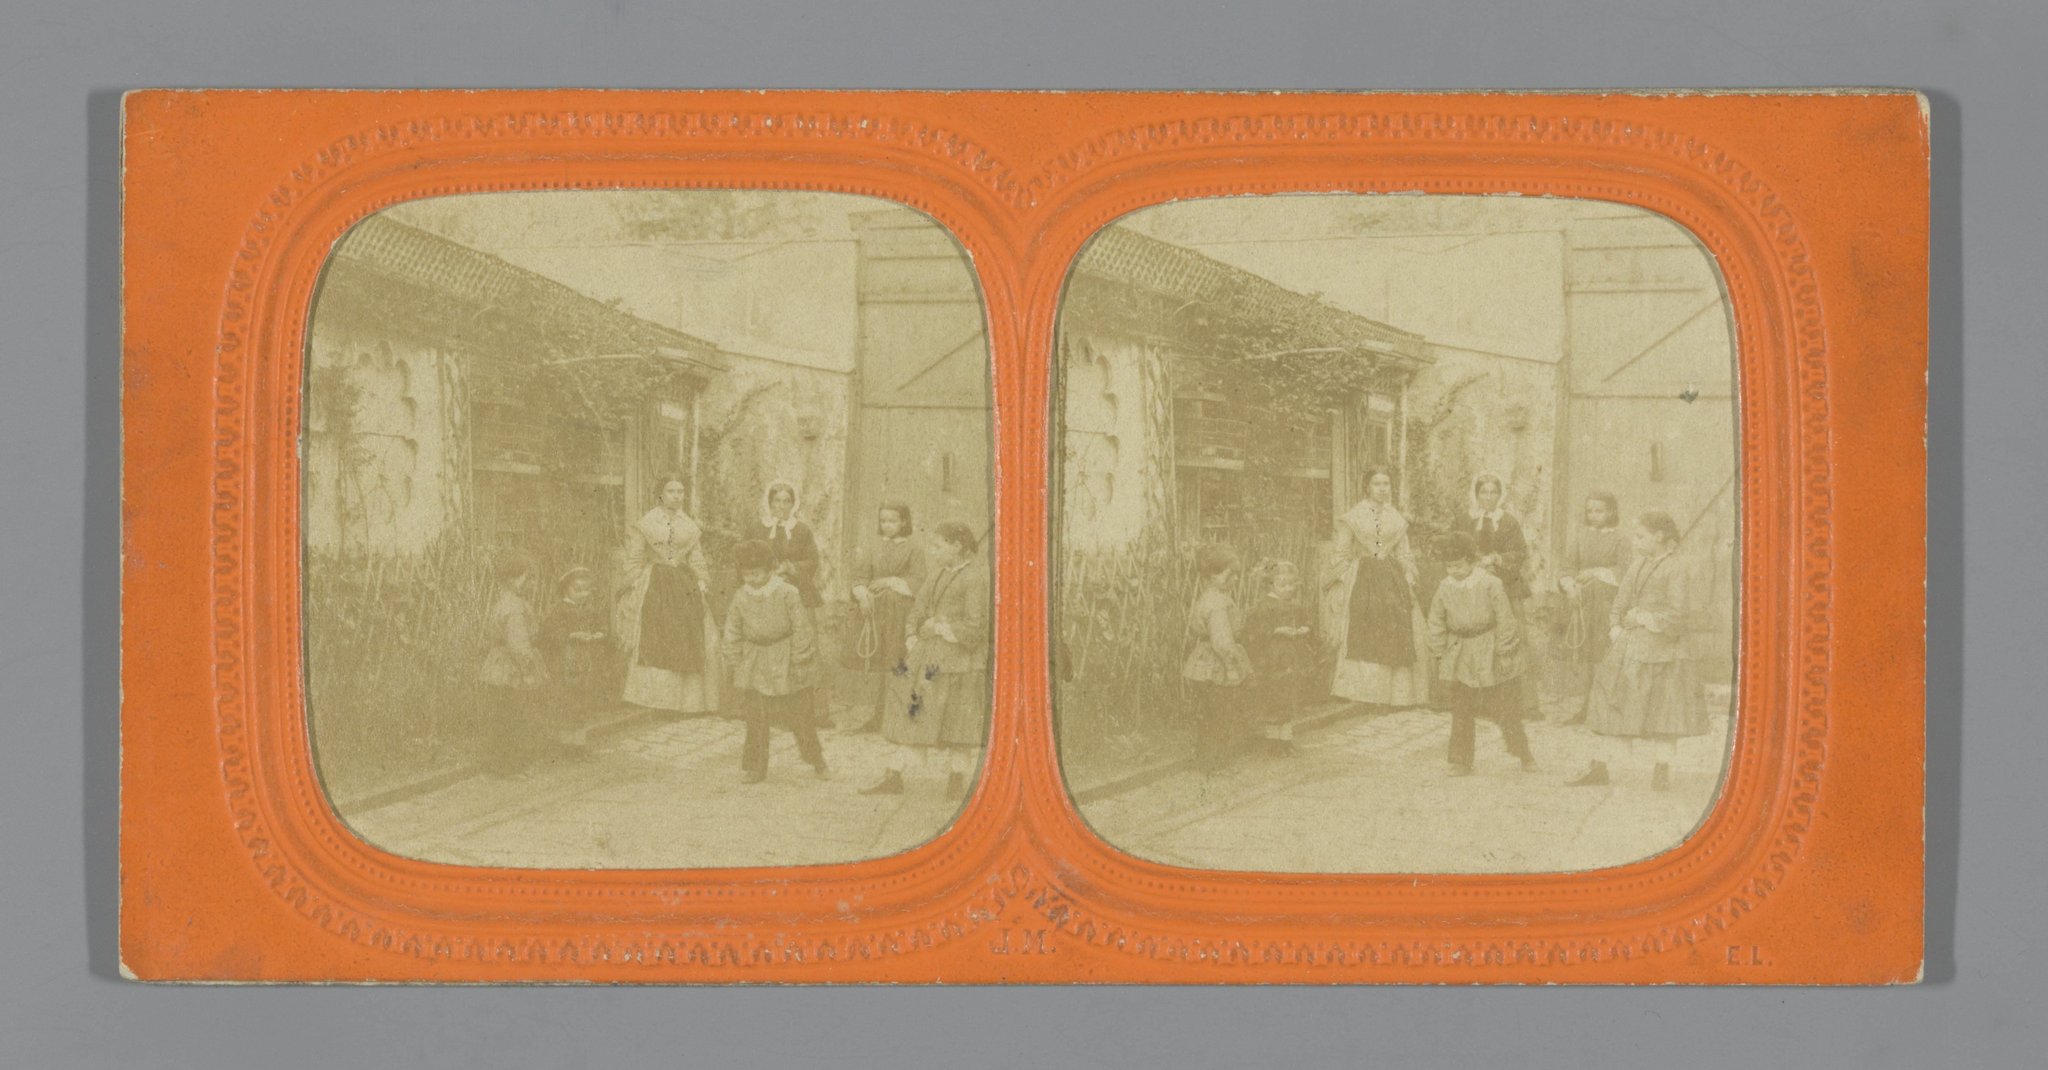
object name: tissue stereograph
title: Kinderen spelen op straat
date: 1864-1880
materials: cardboard, paper, photographic support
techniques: albumen print, hand coloring, perforating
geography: paris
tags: other children's games